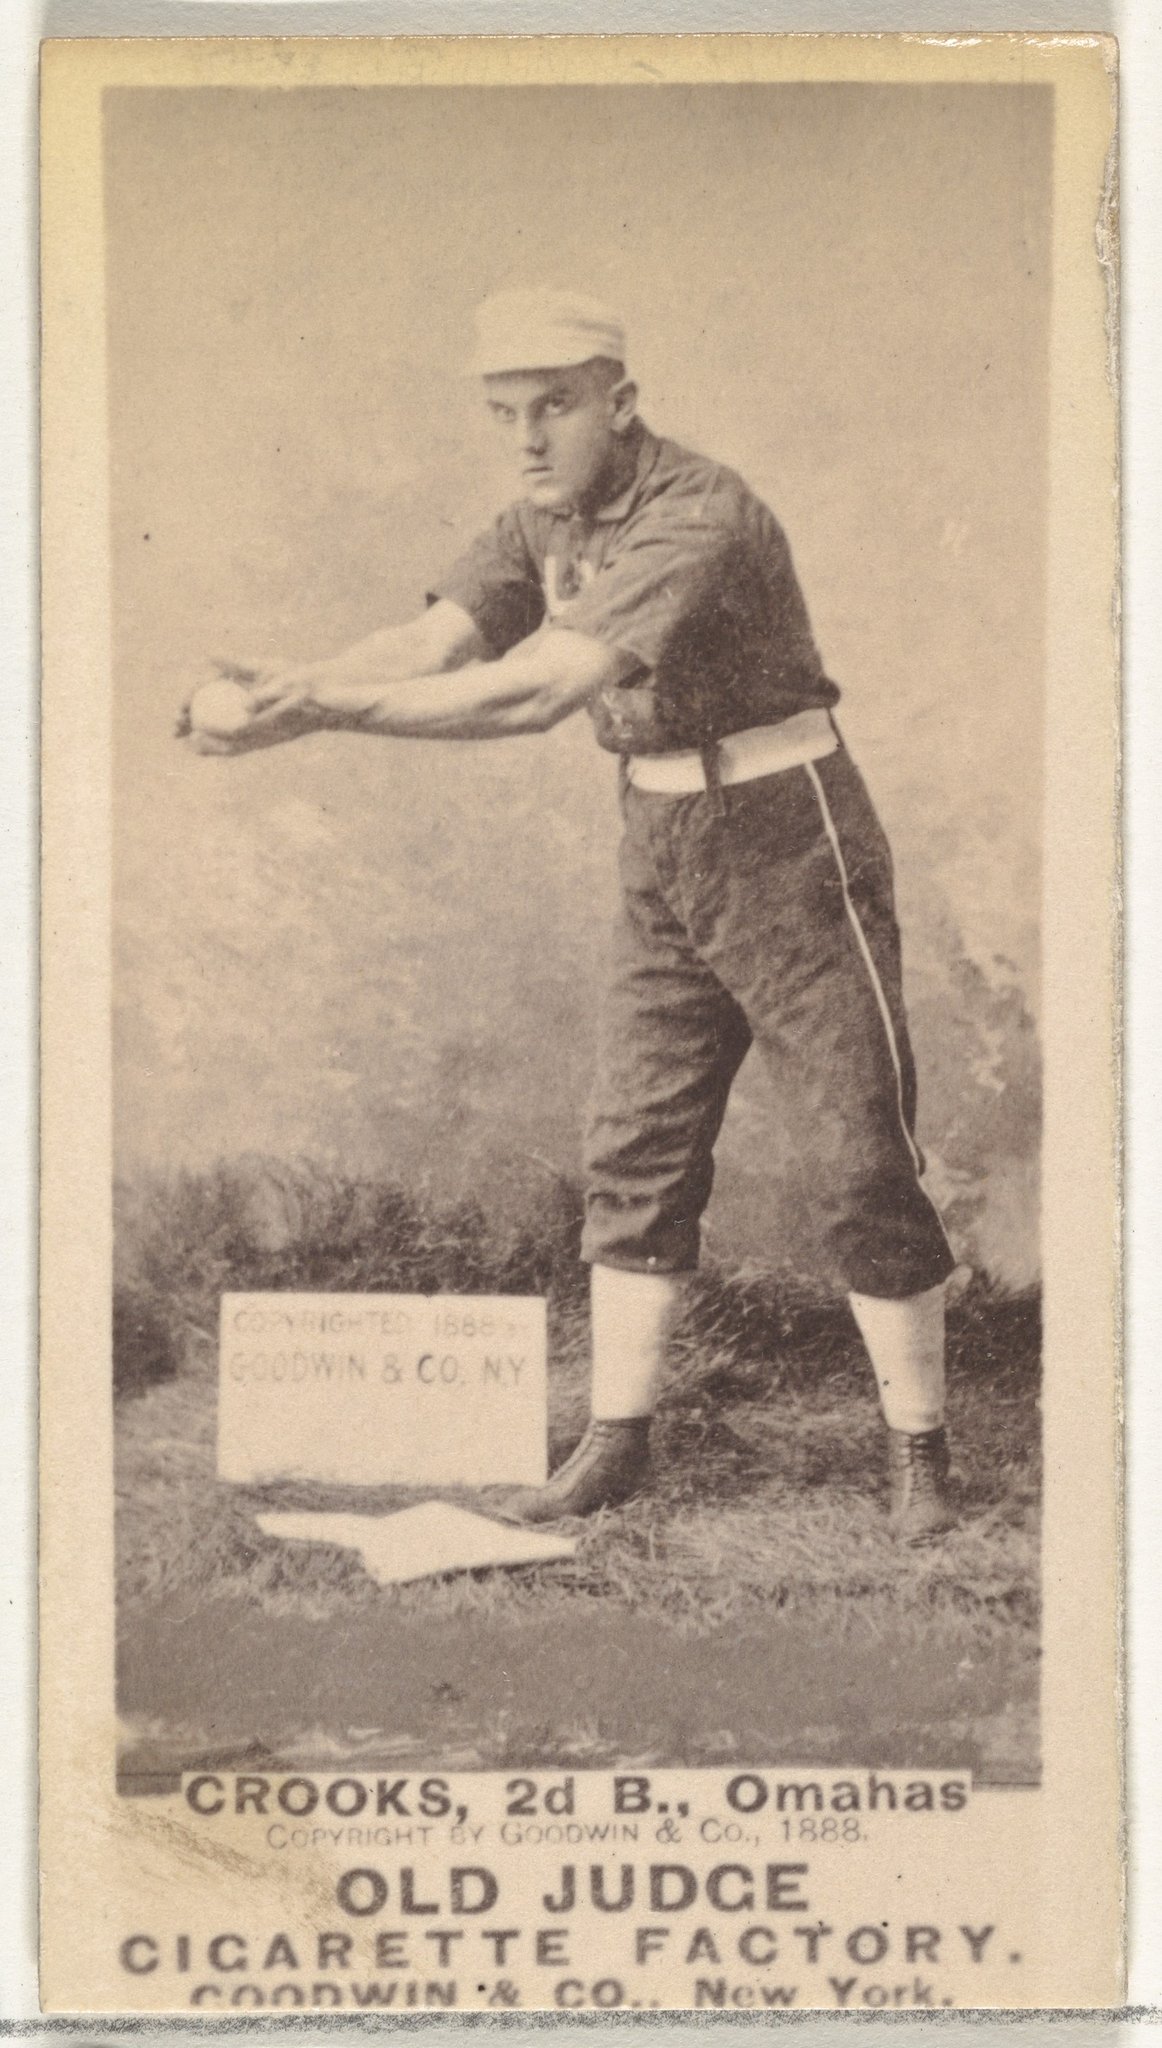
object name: baseball card, photograph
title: John Charles "Jack" Crooks, 2nd Base, Omaha Omahogs/ Lambs, from the Old Judge series (N172) for Old Judge Cigarettes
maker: goodwin & company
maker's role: publisher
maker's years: 1850-1950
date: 1888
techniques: albumen silver print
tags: men,portraits,baseball,athletes